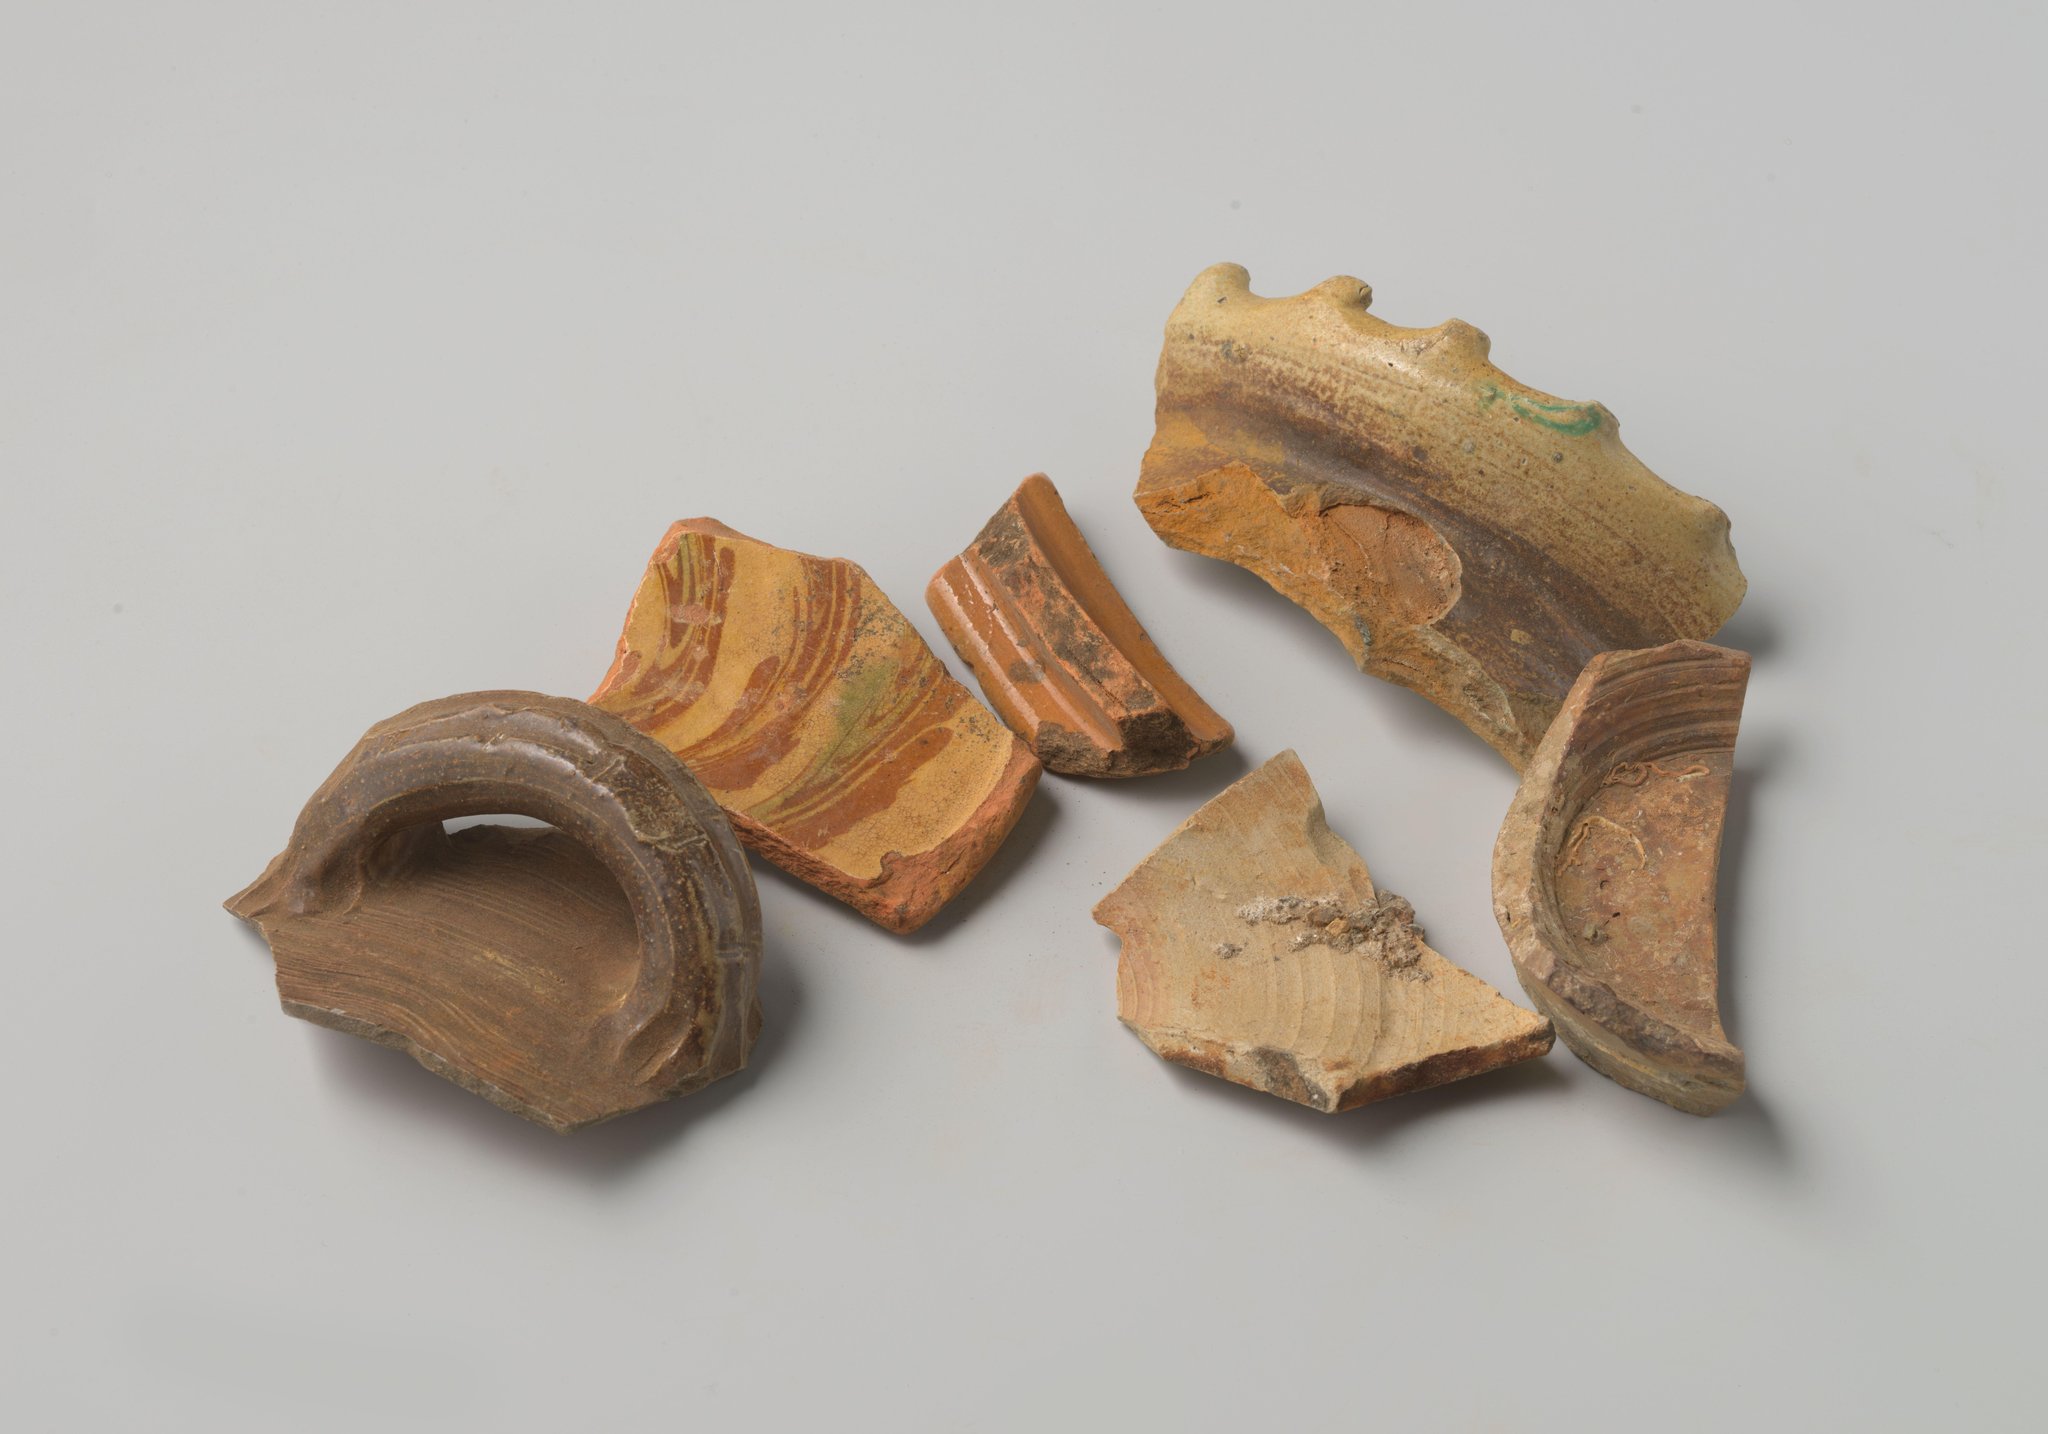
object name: sherd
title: Scherven steengoed en aardewerk uit het wrak van de Oost-Indiëvaarder Hollandia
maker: Anonymous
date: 1700-1743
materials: earthenware, glaze, stoneware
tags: verenigde oostindische compagnie, hollandia (schip), annet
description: Scherven steengoed en roodbakked aardewerk met glazuur.